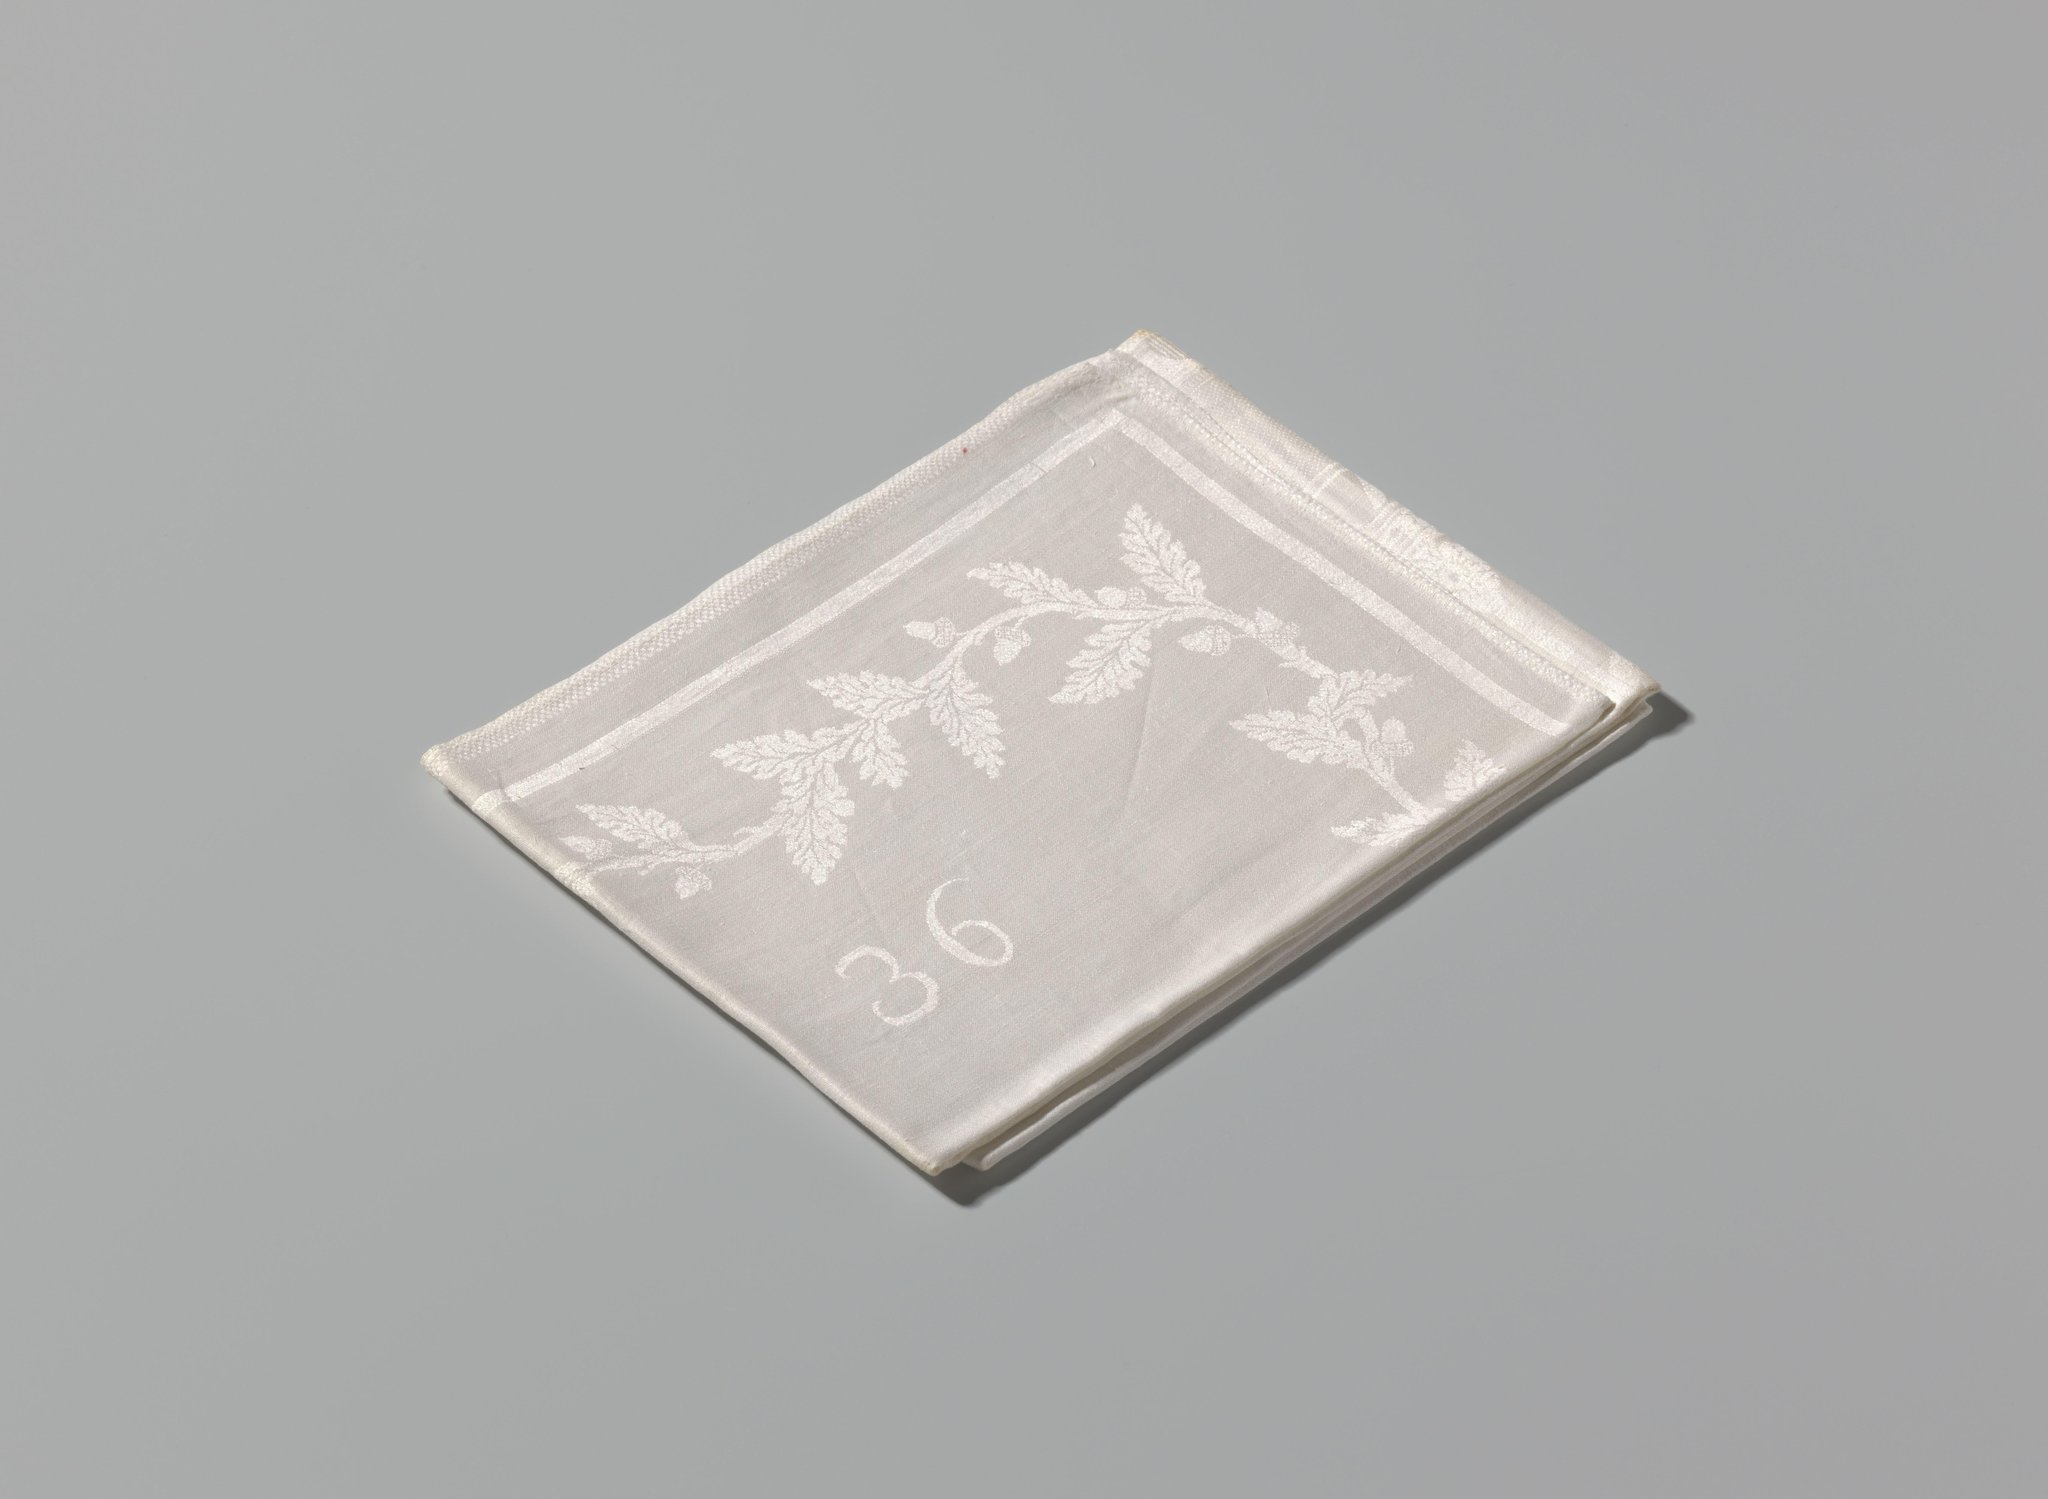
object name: napkin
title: Servet met het wapen van Wijk bij Duurstede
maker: Anonymous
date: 1786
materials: linen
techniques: damask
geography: north brabant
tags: wijk bij duurstede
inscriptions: mark: ‘3’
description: Servet van linnendamast met het wapen van Wijk bij Duurstede. Middenveld: In de breedte geplaatst voor een speer met vrijheidshoed, het wapen van Wijk bij Duurstede: goud met balk van keel, beladen met drie zuilen; het is omgeven door twee lauwertakken en rust op een trofee van bajonetten, vlaggen, vuurmond en fascesbundel. Daaronder: 20 MAART Ao 1786 en daarboven DAN 36. Randen: slingerende tak met eikebladeren en eikels, een effen bandlijst en een blokkenrand.